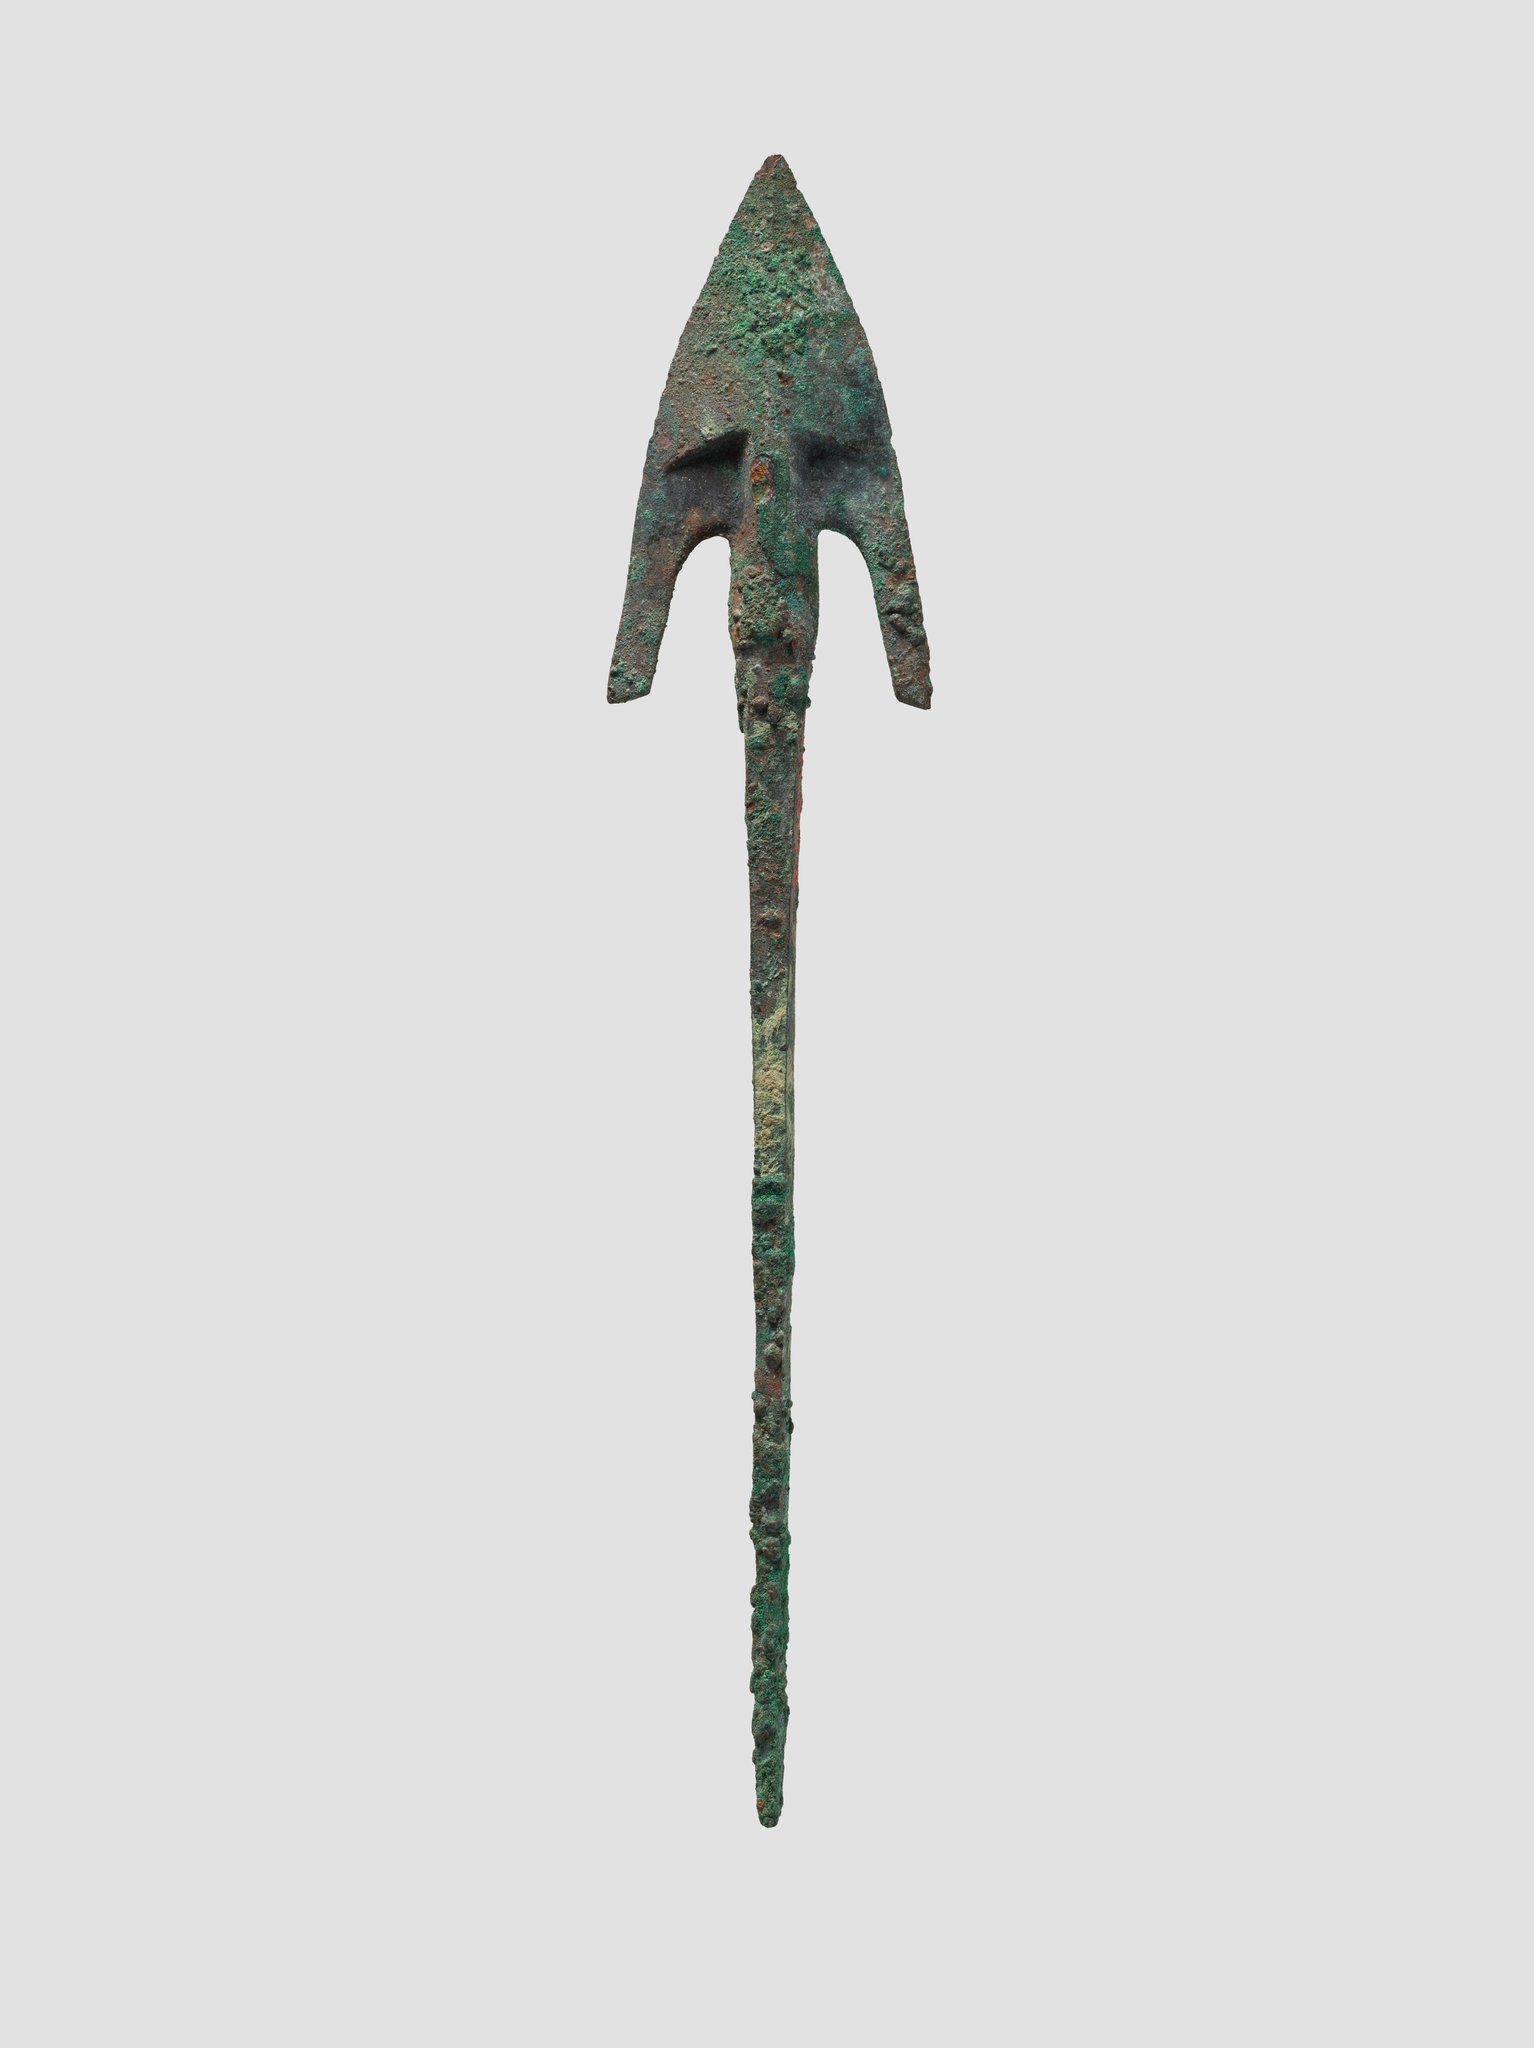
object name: arrowhead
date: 1000-668 BCE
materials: bronze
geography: transcaucasia